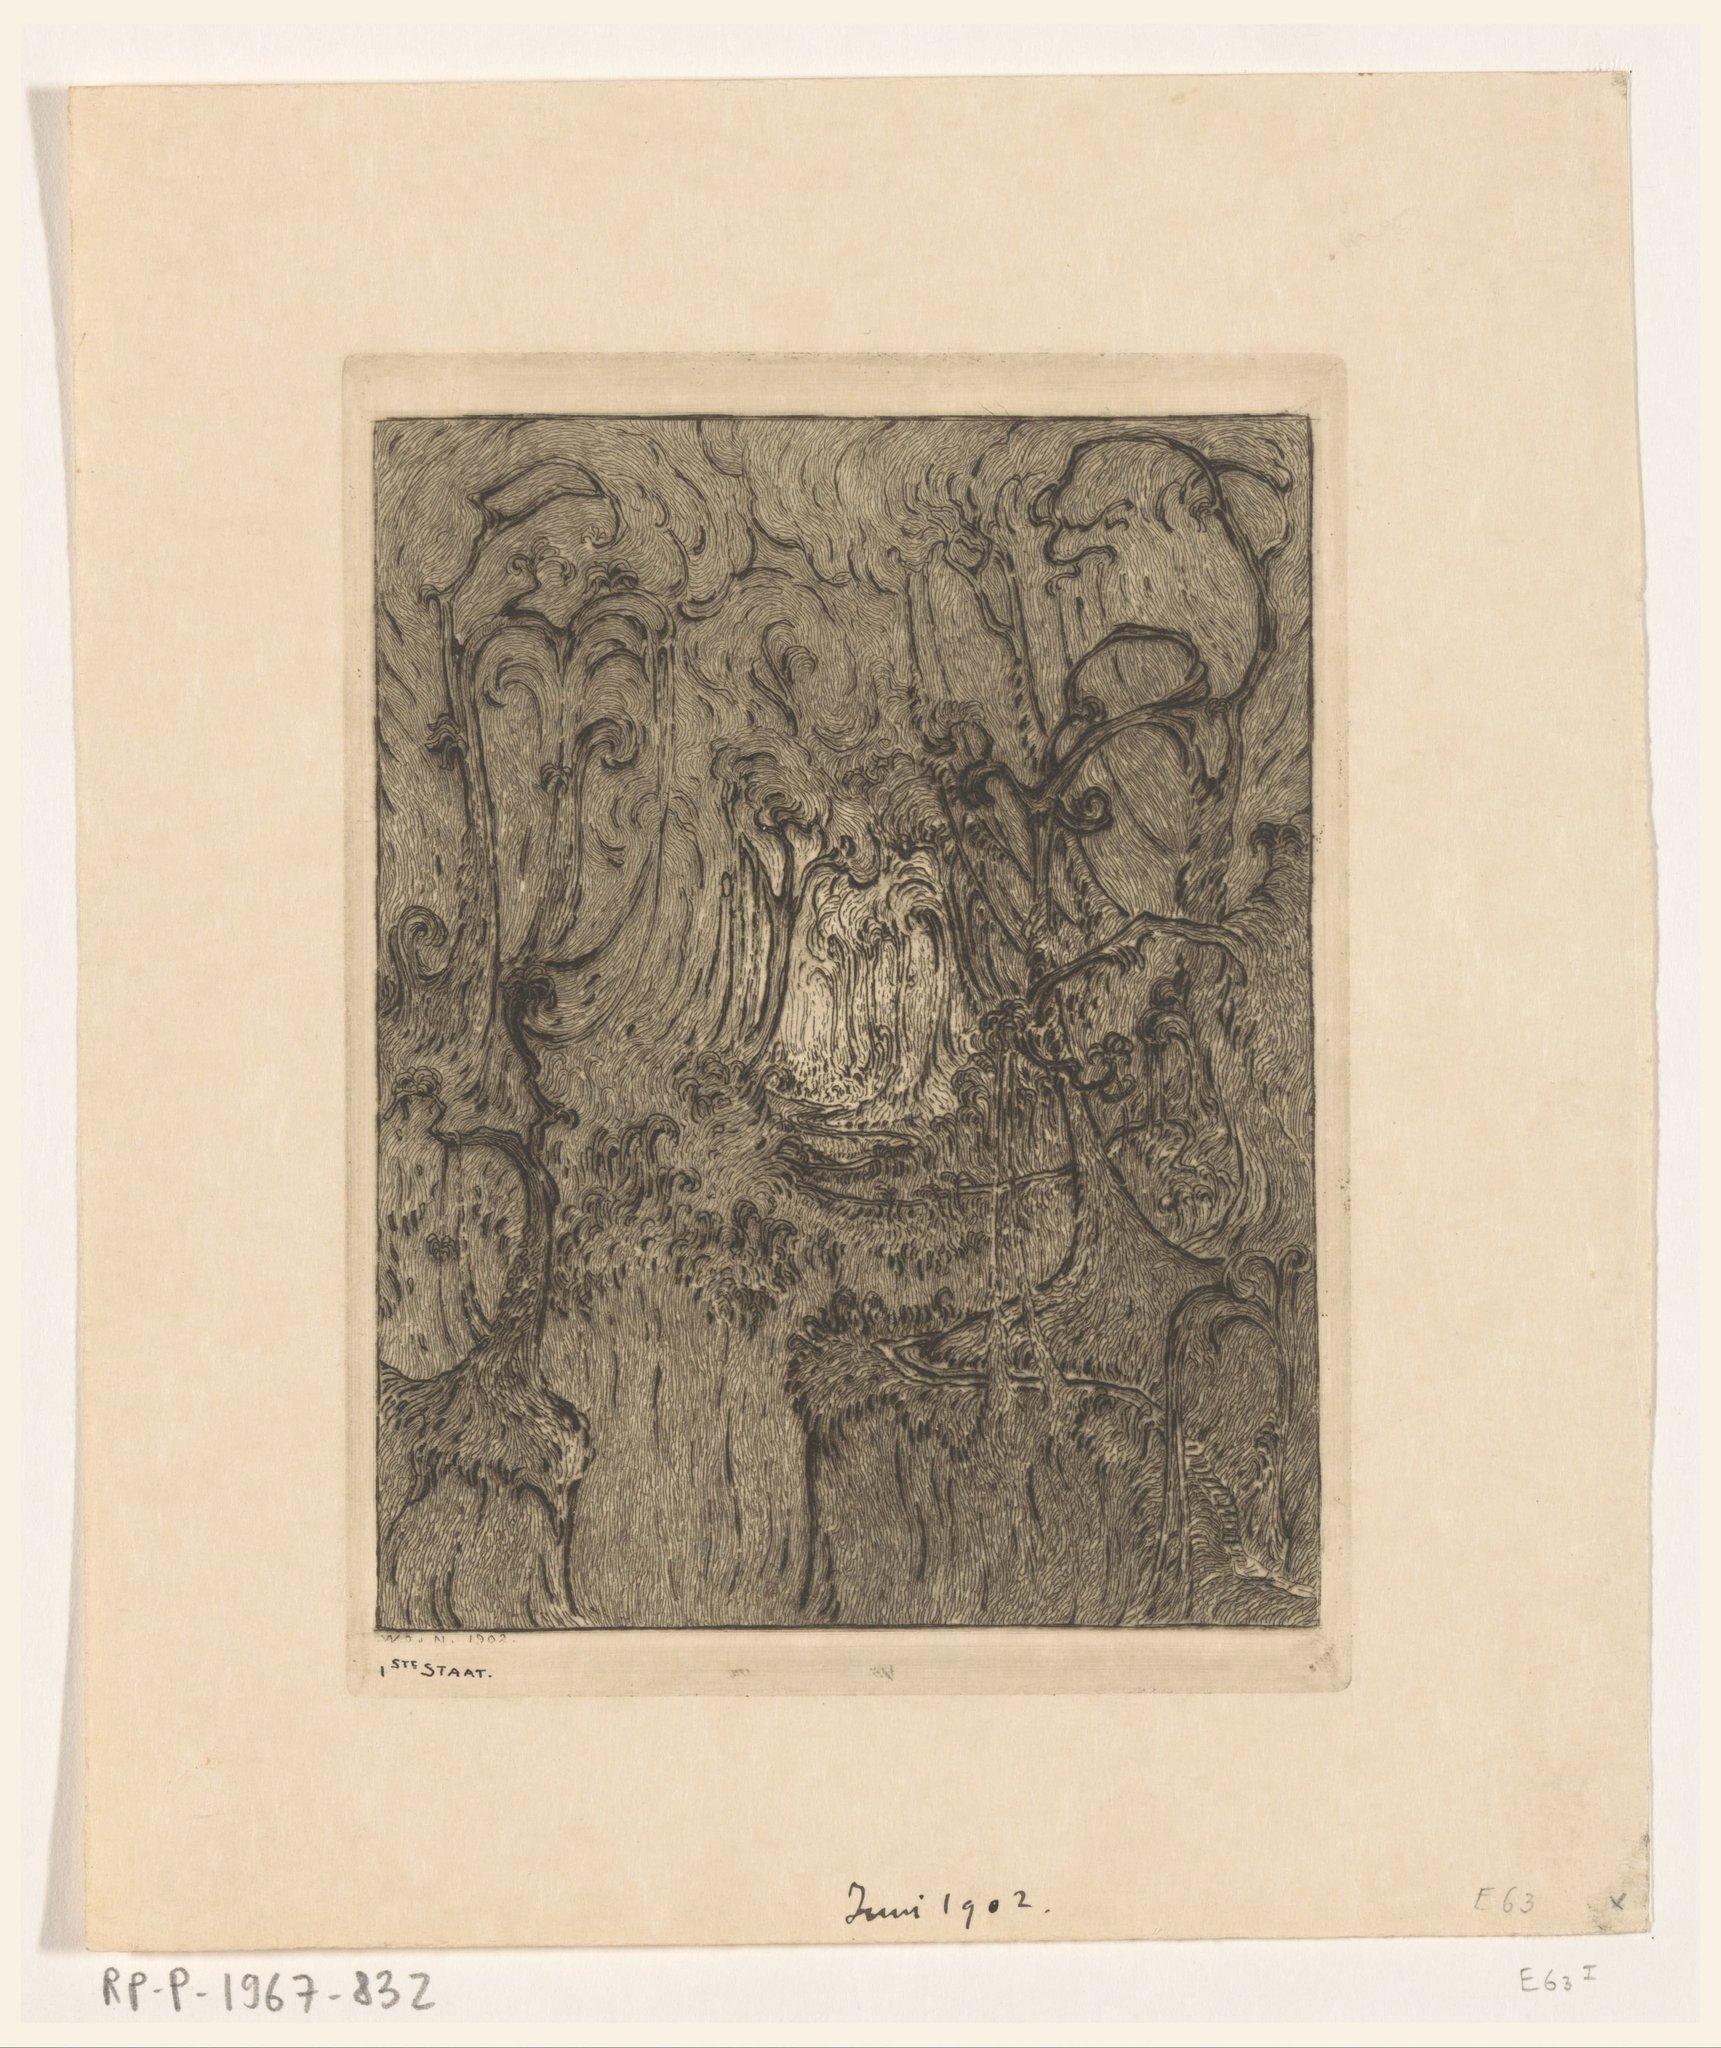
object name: print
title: Een weg door het woud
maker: wijnand otto jan nieuwenkamp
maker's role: draughtsman, print maker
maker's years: 1874-1950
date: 1902-1906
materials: paper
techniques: etching, intaglio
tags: jungle, java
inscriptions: collector's mark: Lugt 2760, collector's mark: Lugt 2228